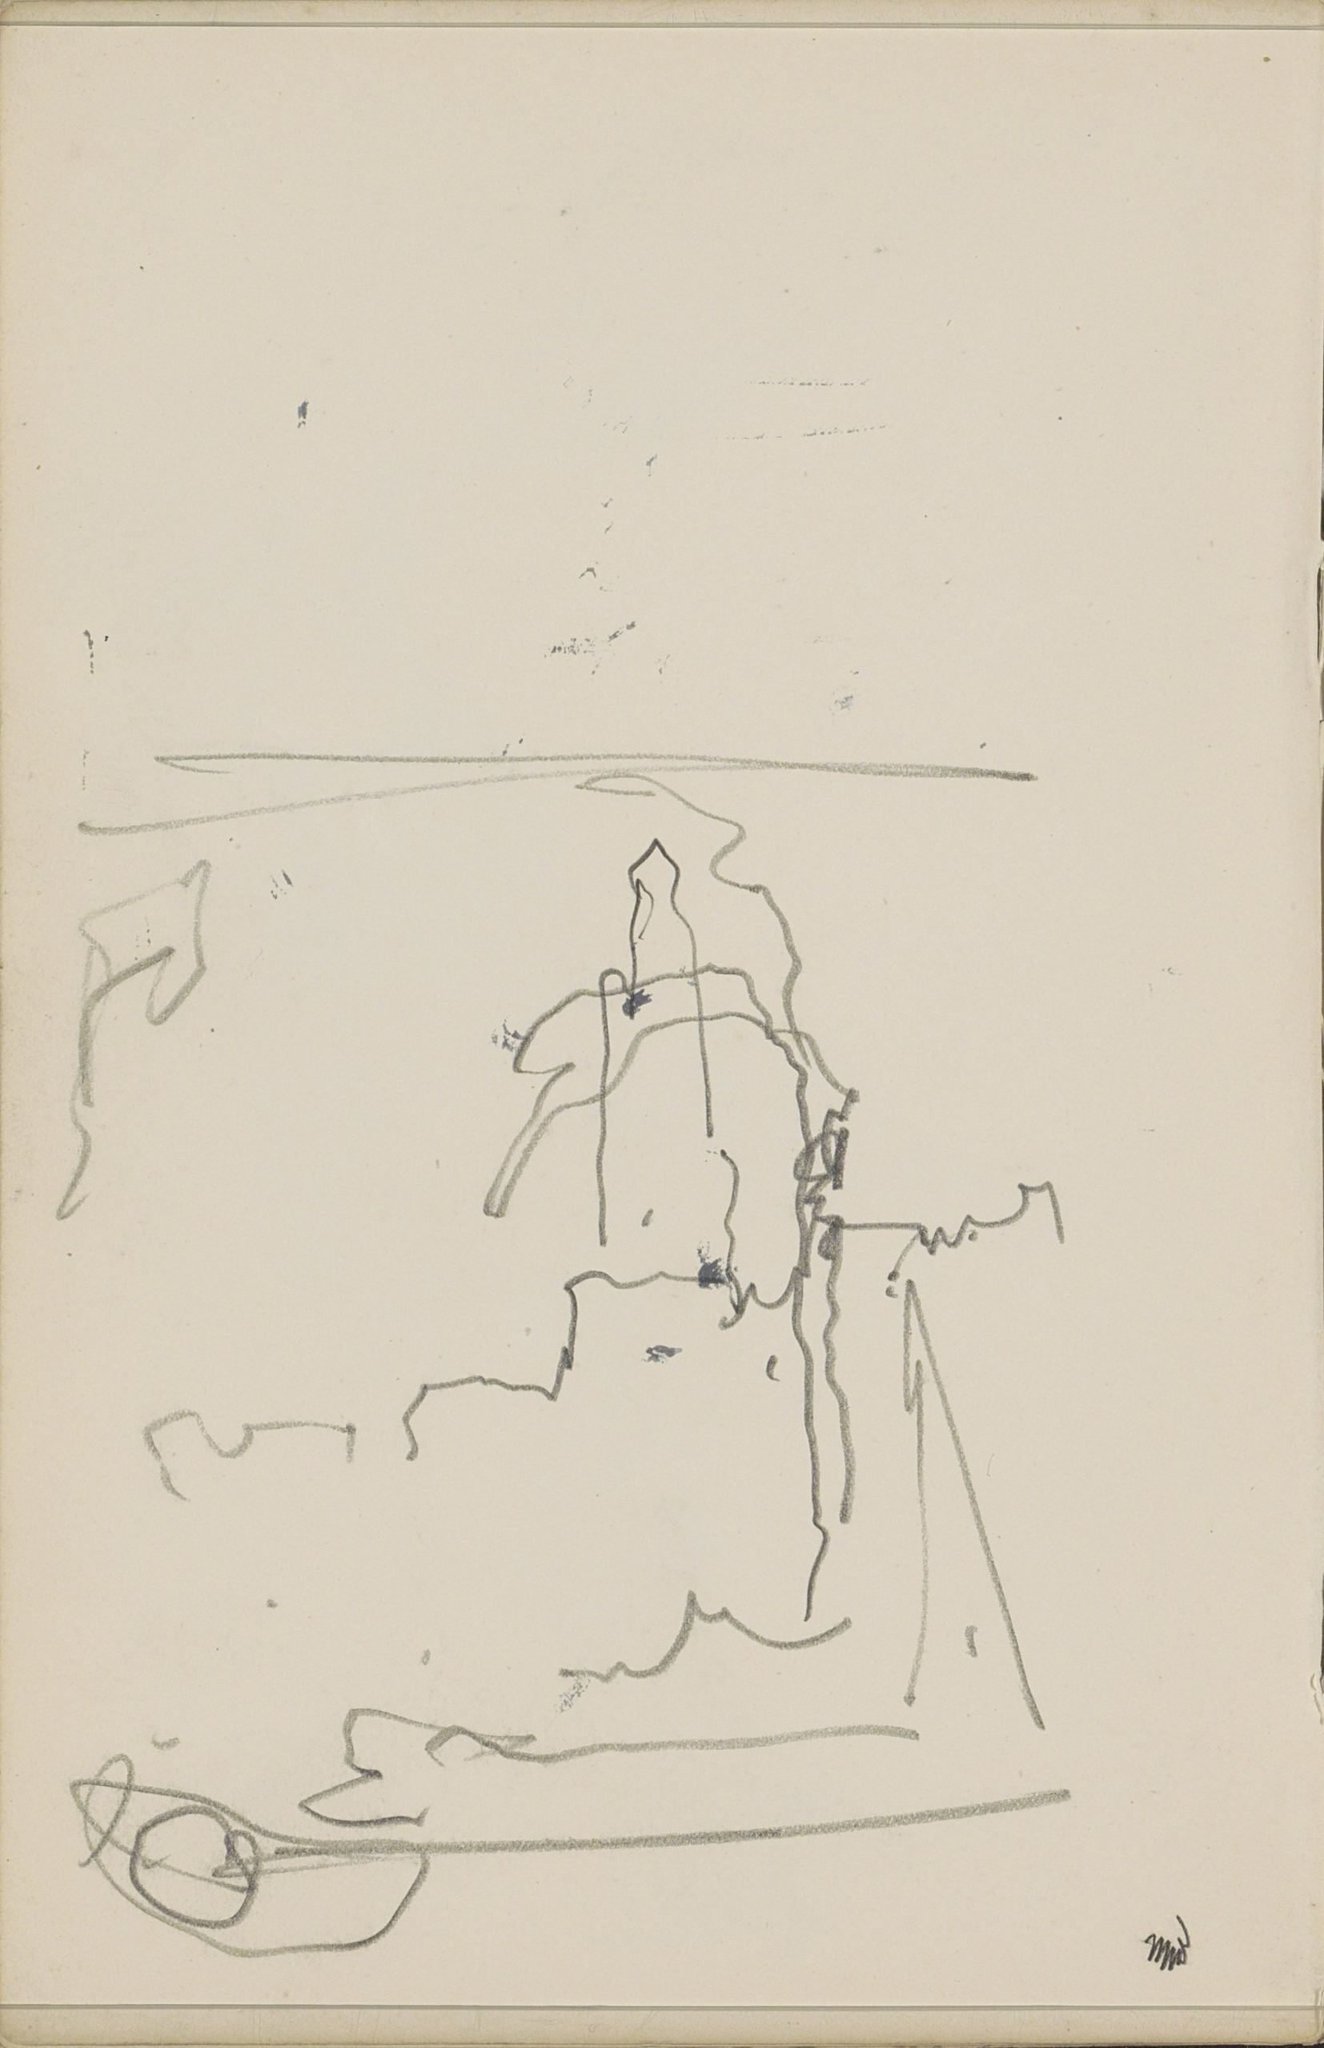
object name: sketchbook leaf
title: Stadsgezicht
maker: cornelis vreedenburgh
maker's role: draughtsman, print maker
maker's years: 1880-1946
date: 1890-1946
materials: paper, pencil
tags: city-view, and landscape with man-made constructions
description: Blad 33 verso uit een schetsboek met 45 bladen.